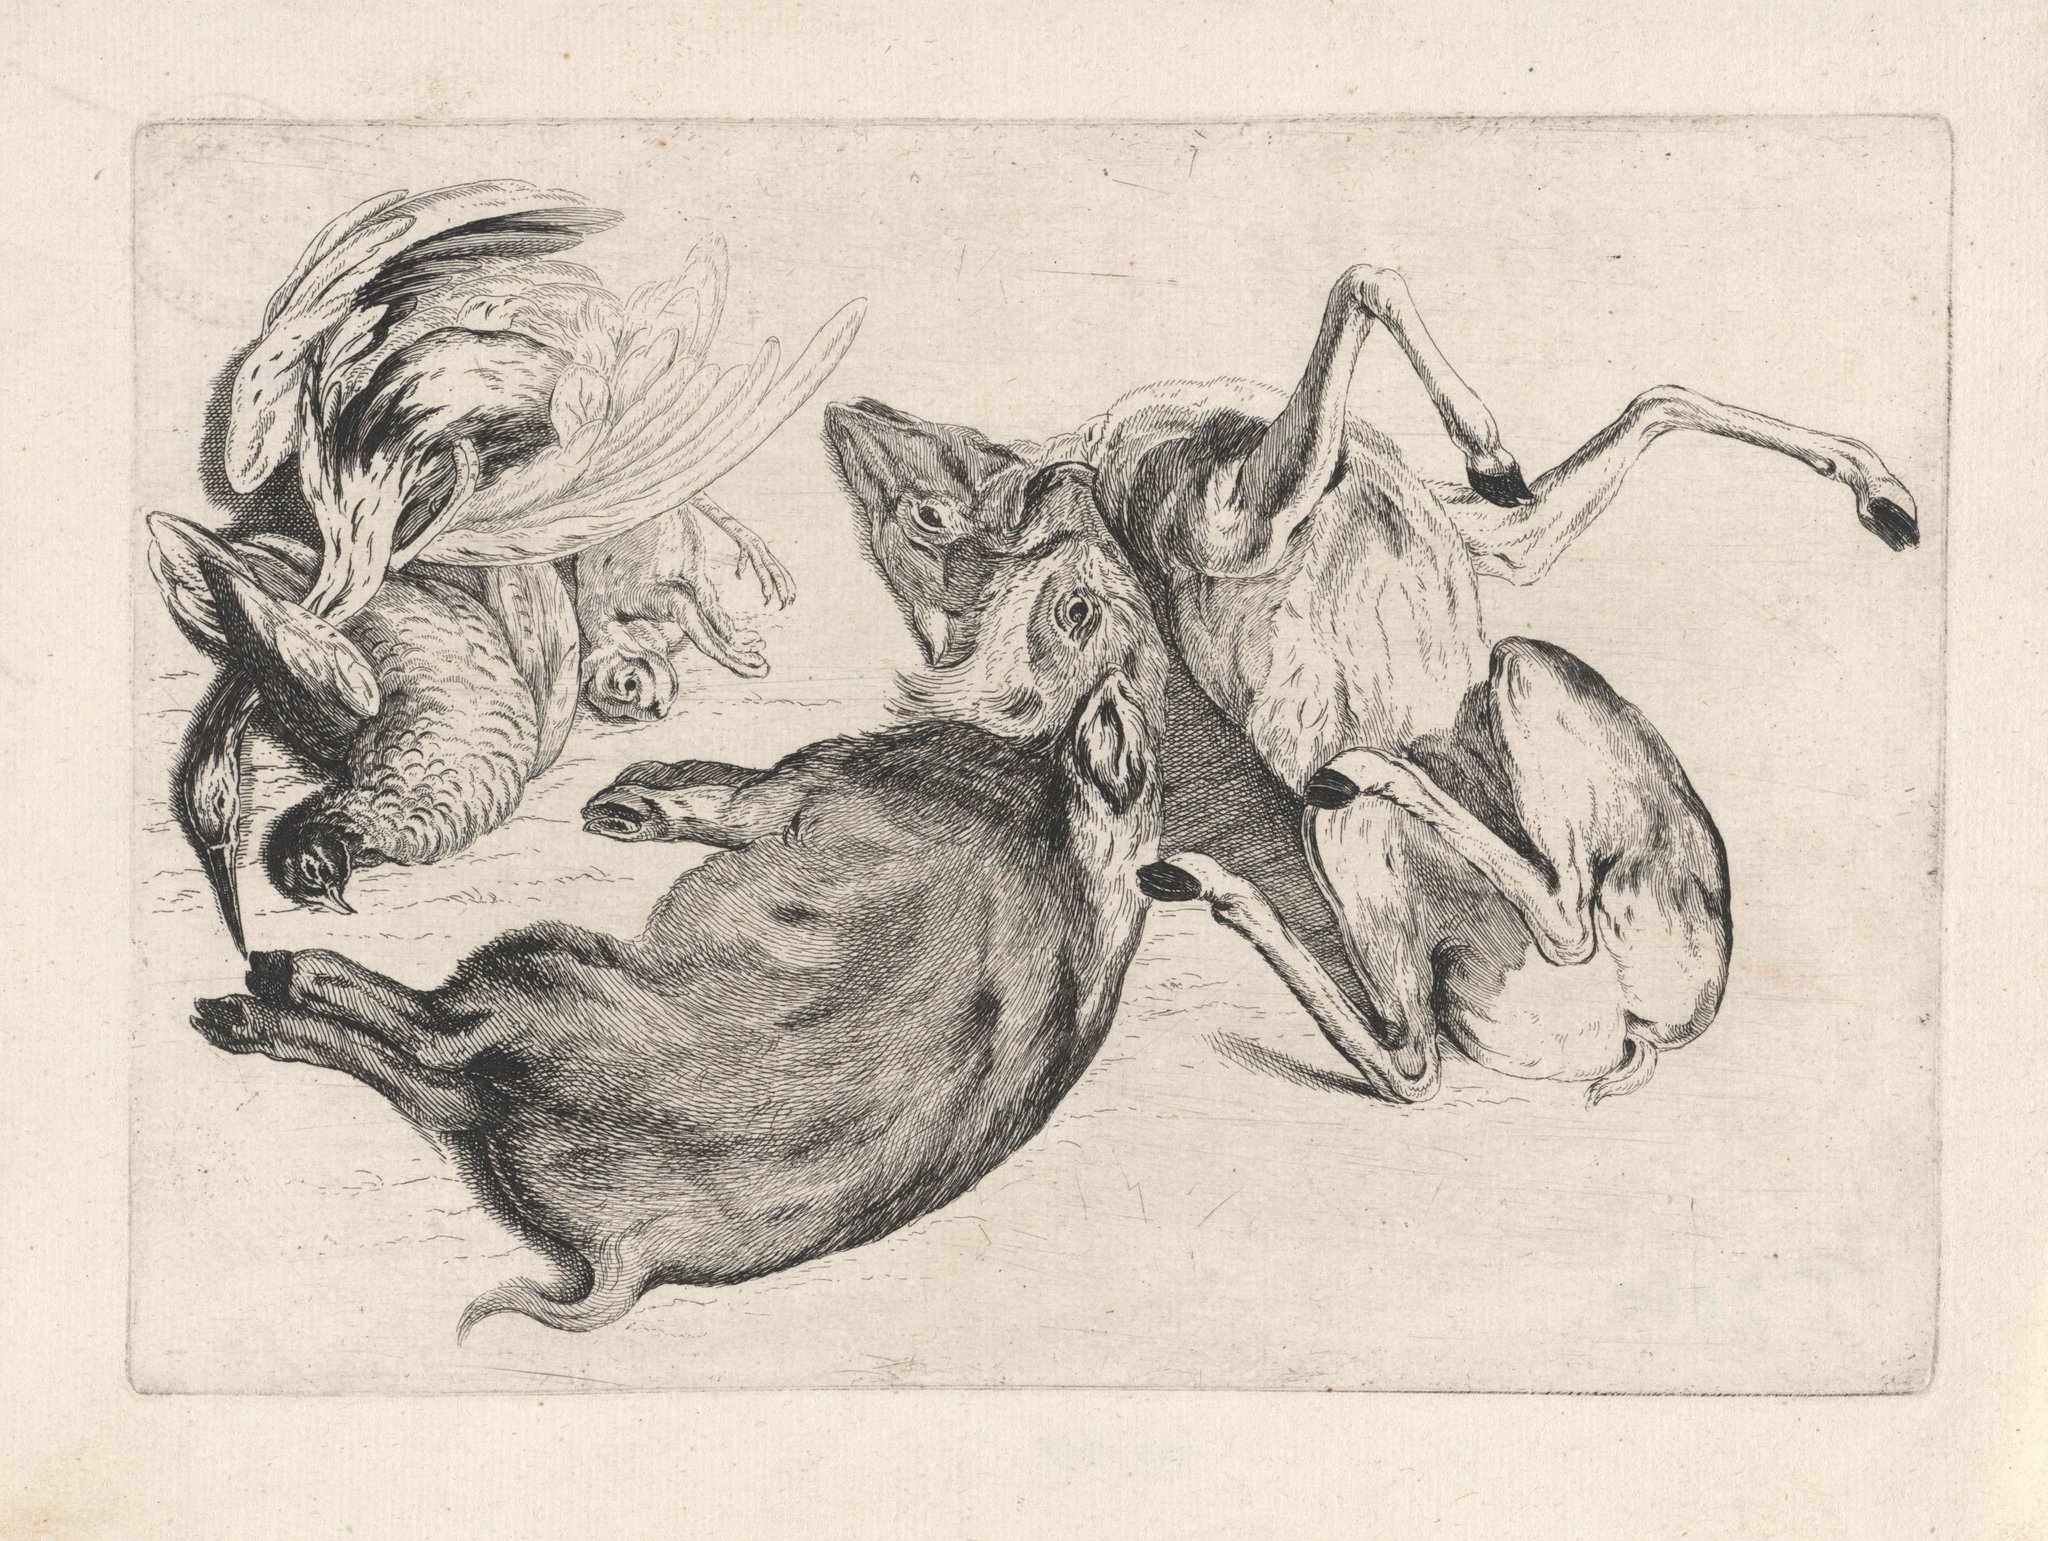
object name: print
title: Jacht, jachthonden en wild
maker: Anonymous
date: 1646-1647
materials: paper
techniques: etching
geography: antwerp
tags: hoofed animals: deer, shore-birds and wading-birds: heron, birds, hoofed animals: boar, spoils of the hunt, game, venison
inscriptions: collector's mark: Lugt 240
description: Prent uit twintigdelige serie (incl. titelprent) met voorstellingen over de jacht: "Jacht, jachthonden en wild".